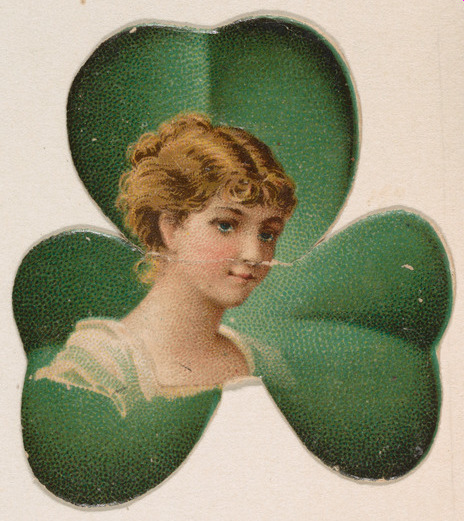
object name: print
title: Three-leaf clover, from the Novelties series (N228, Type 4) issued by Kinney Bros.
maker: kinney brothers tobacco company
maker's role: publisher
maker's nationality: american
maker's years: 1869-2011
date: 1889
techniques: color lithograph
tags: women,leaves